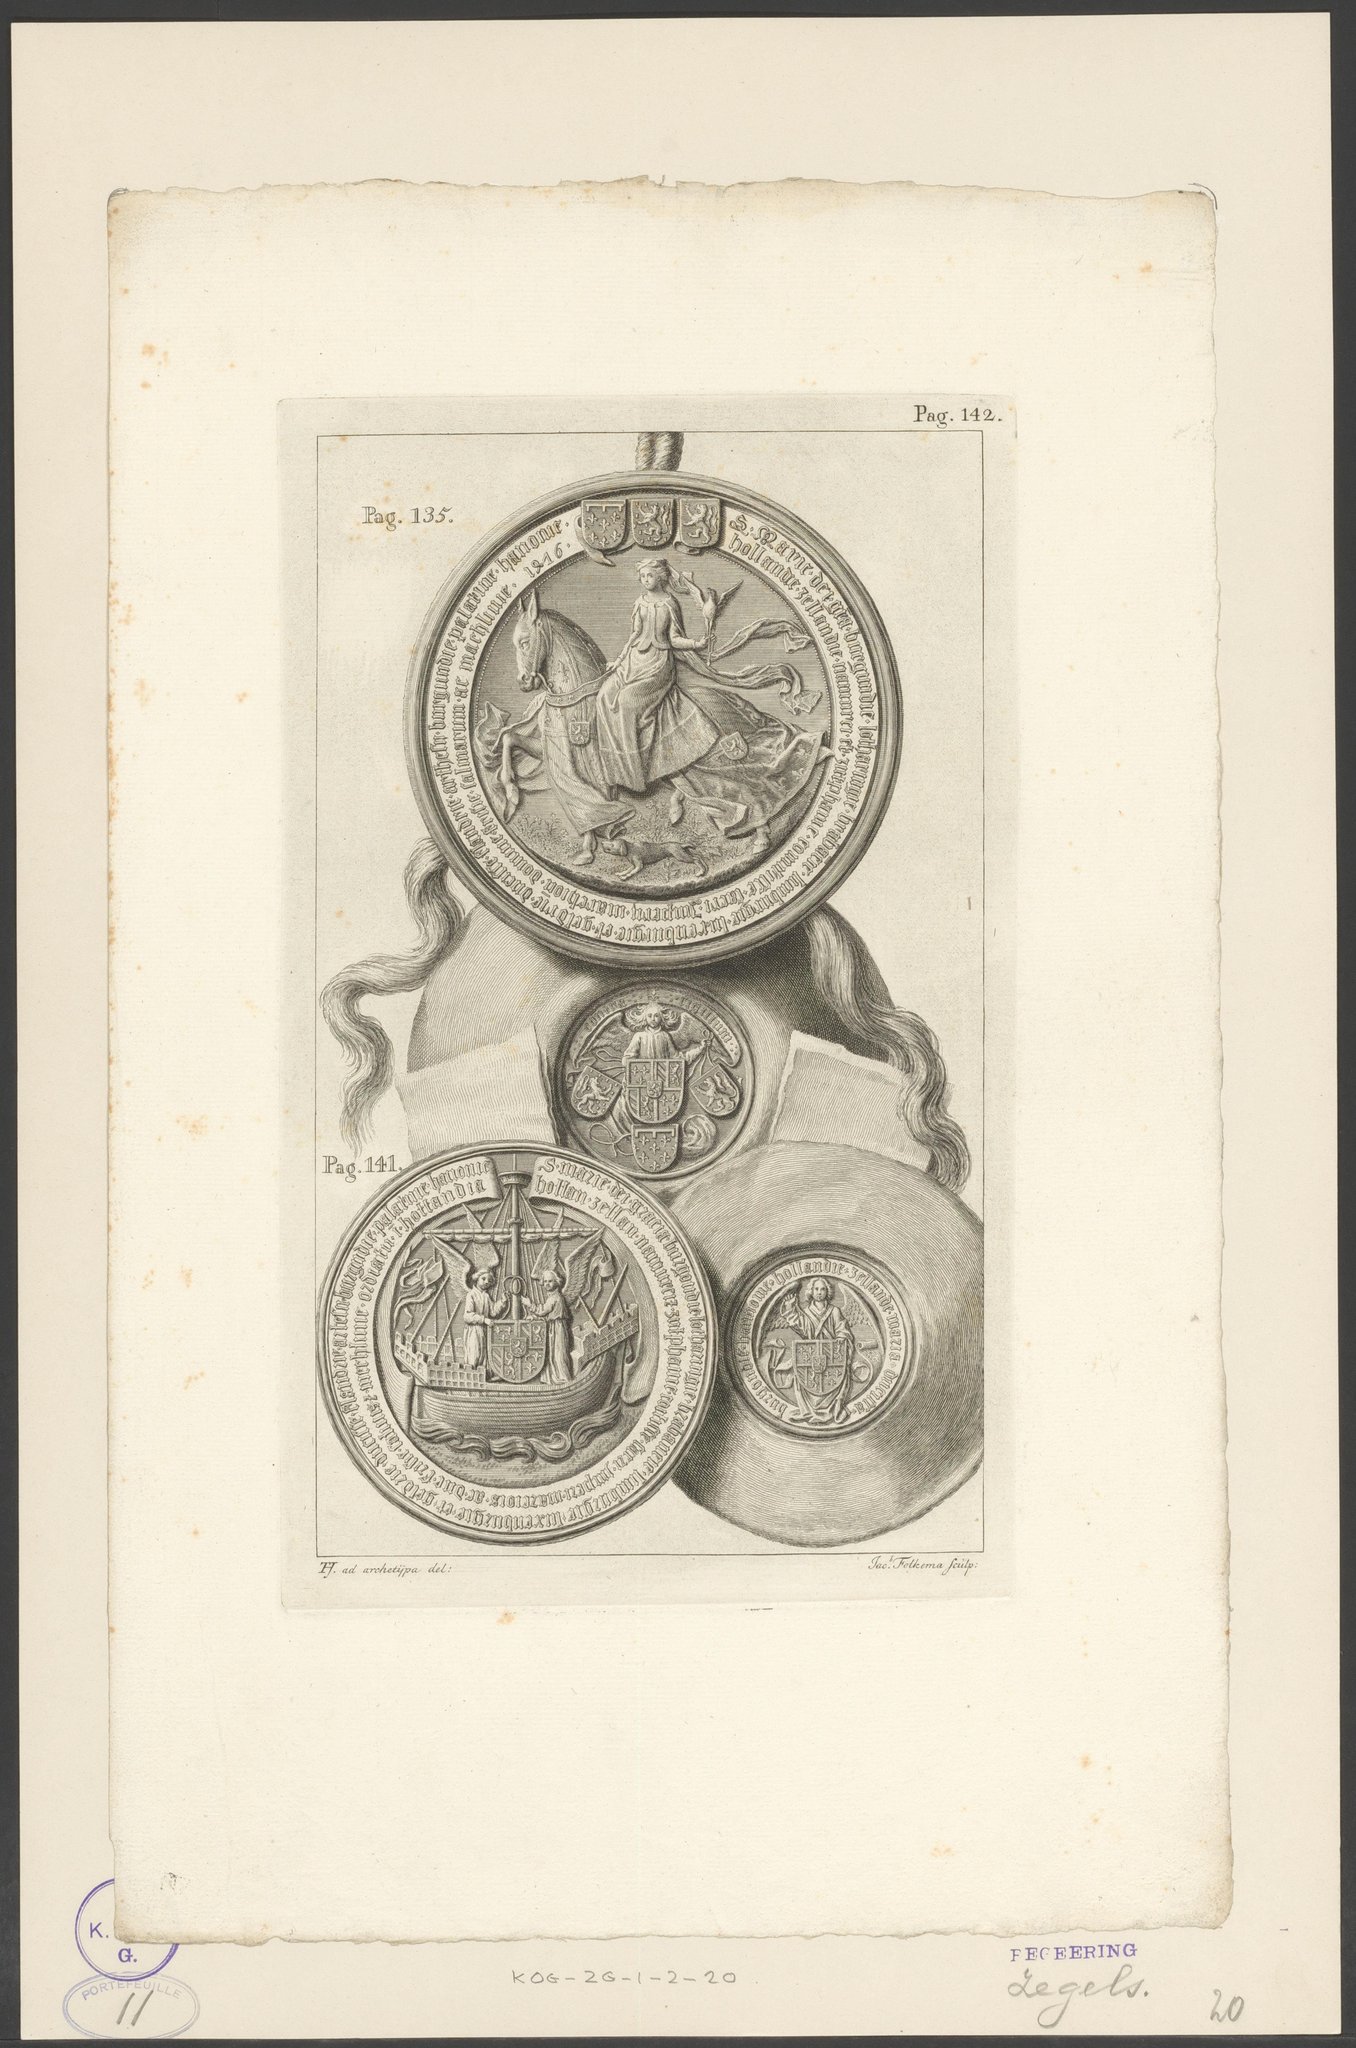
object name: print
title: Blad met zegels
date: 1751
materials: paper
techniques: engraving, etching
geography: netherlands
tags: seal, stamp, seal (as symbol of the state, etc.)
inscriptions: collector's mark, collector's mark: Lugt 1641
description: Diverse zegels, Pag. 142. Met verwijzingen naar andere nummers en paginanummers. Onderwerpsrubrieken binnen de Atlas Zeden en Gewoonten: Regeering, Zegels.